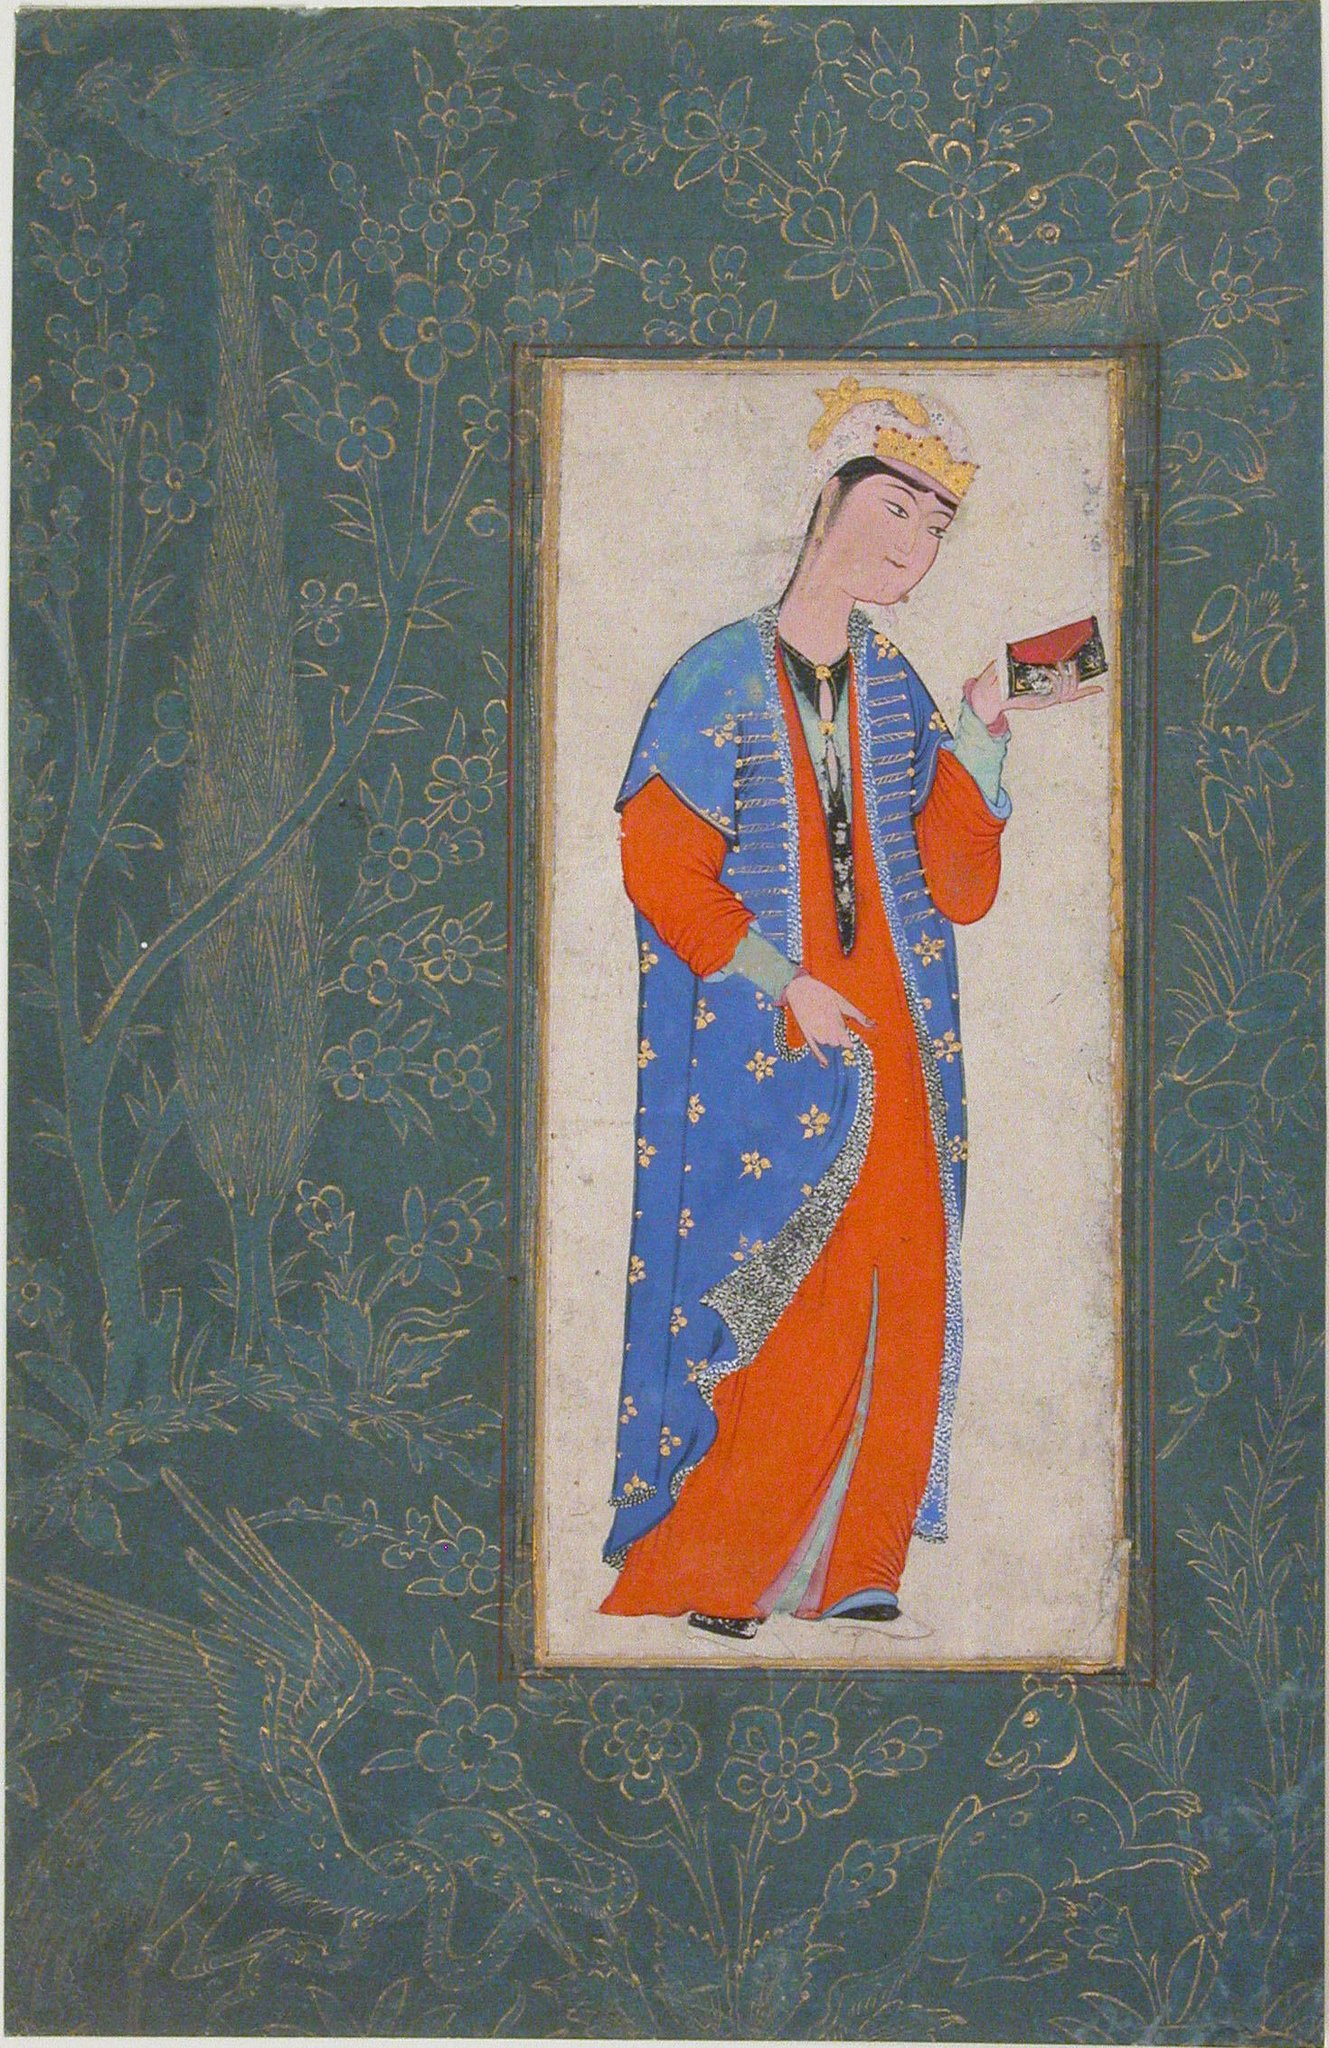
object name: illustrated single work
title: Portrait of a Woman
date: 1501-1600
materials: paper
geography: iran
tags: portraits,women